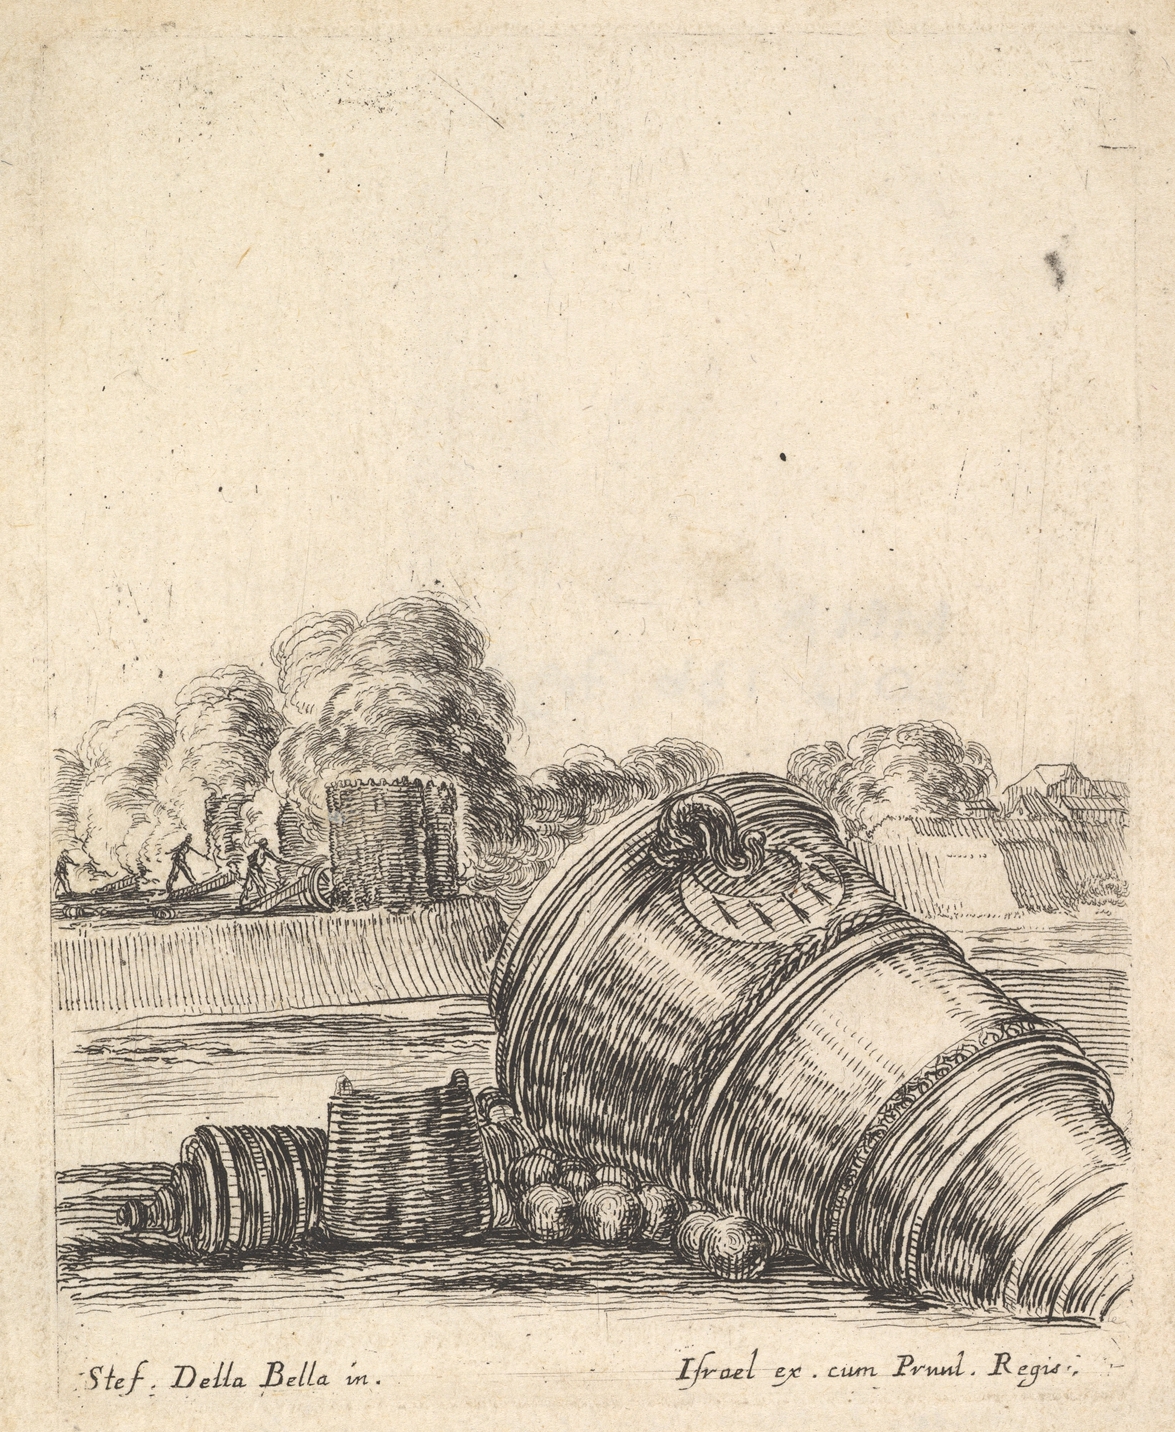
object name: print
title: A mortar without a carriage lying on the ground to the right, soldiers firing cannons creating clouds of smoke in the background, from "Equipment needed for Fortification" (Recueil de diverses pièces très nécessaires à la fortification)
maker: stefano della bella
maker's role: artist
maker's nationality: italian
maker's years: 1610-1664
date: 1638-1643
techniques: etching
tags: human figures,fortification,cannons